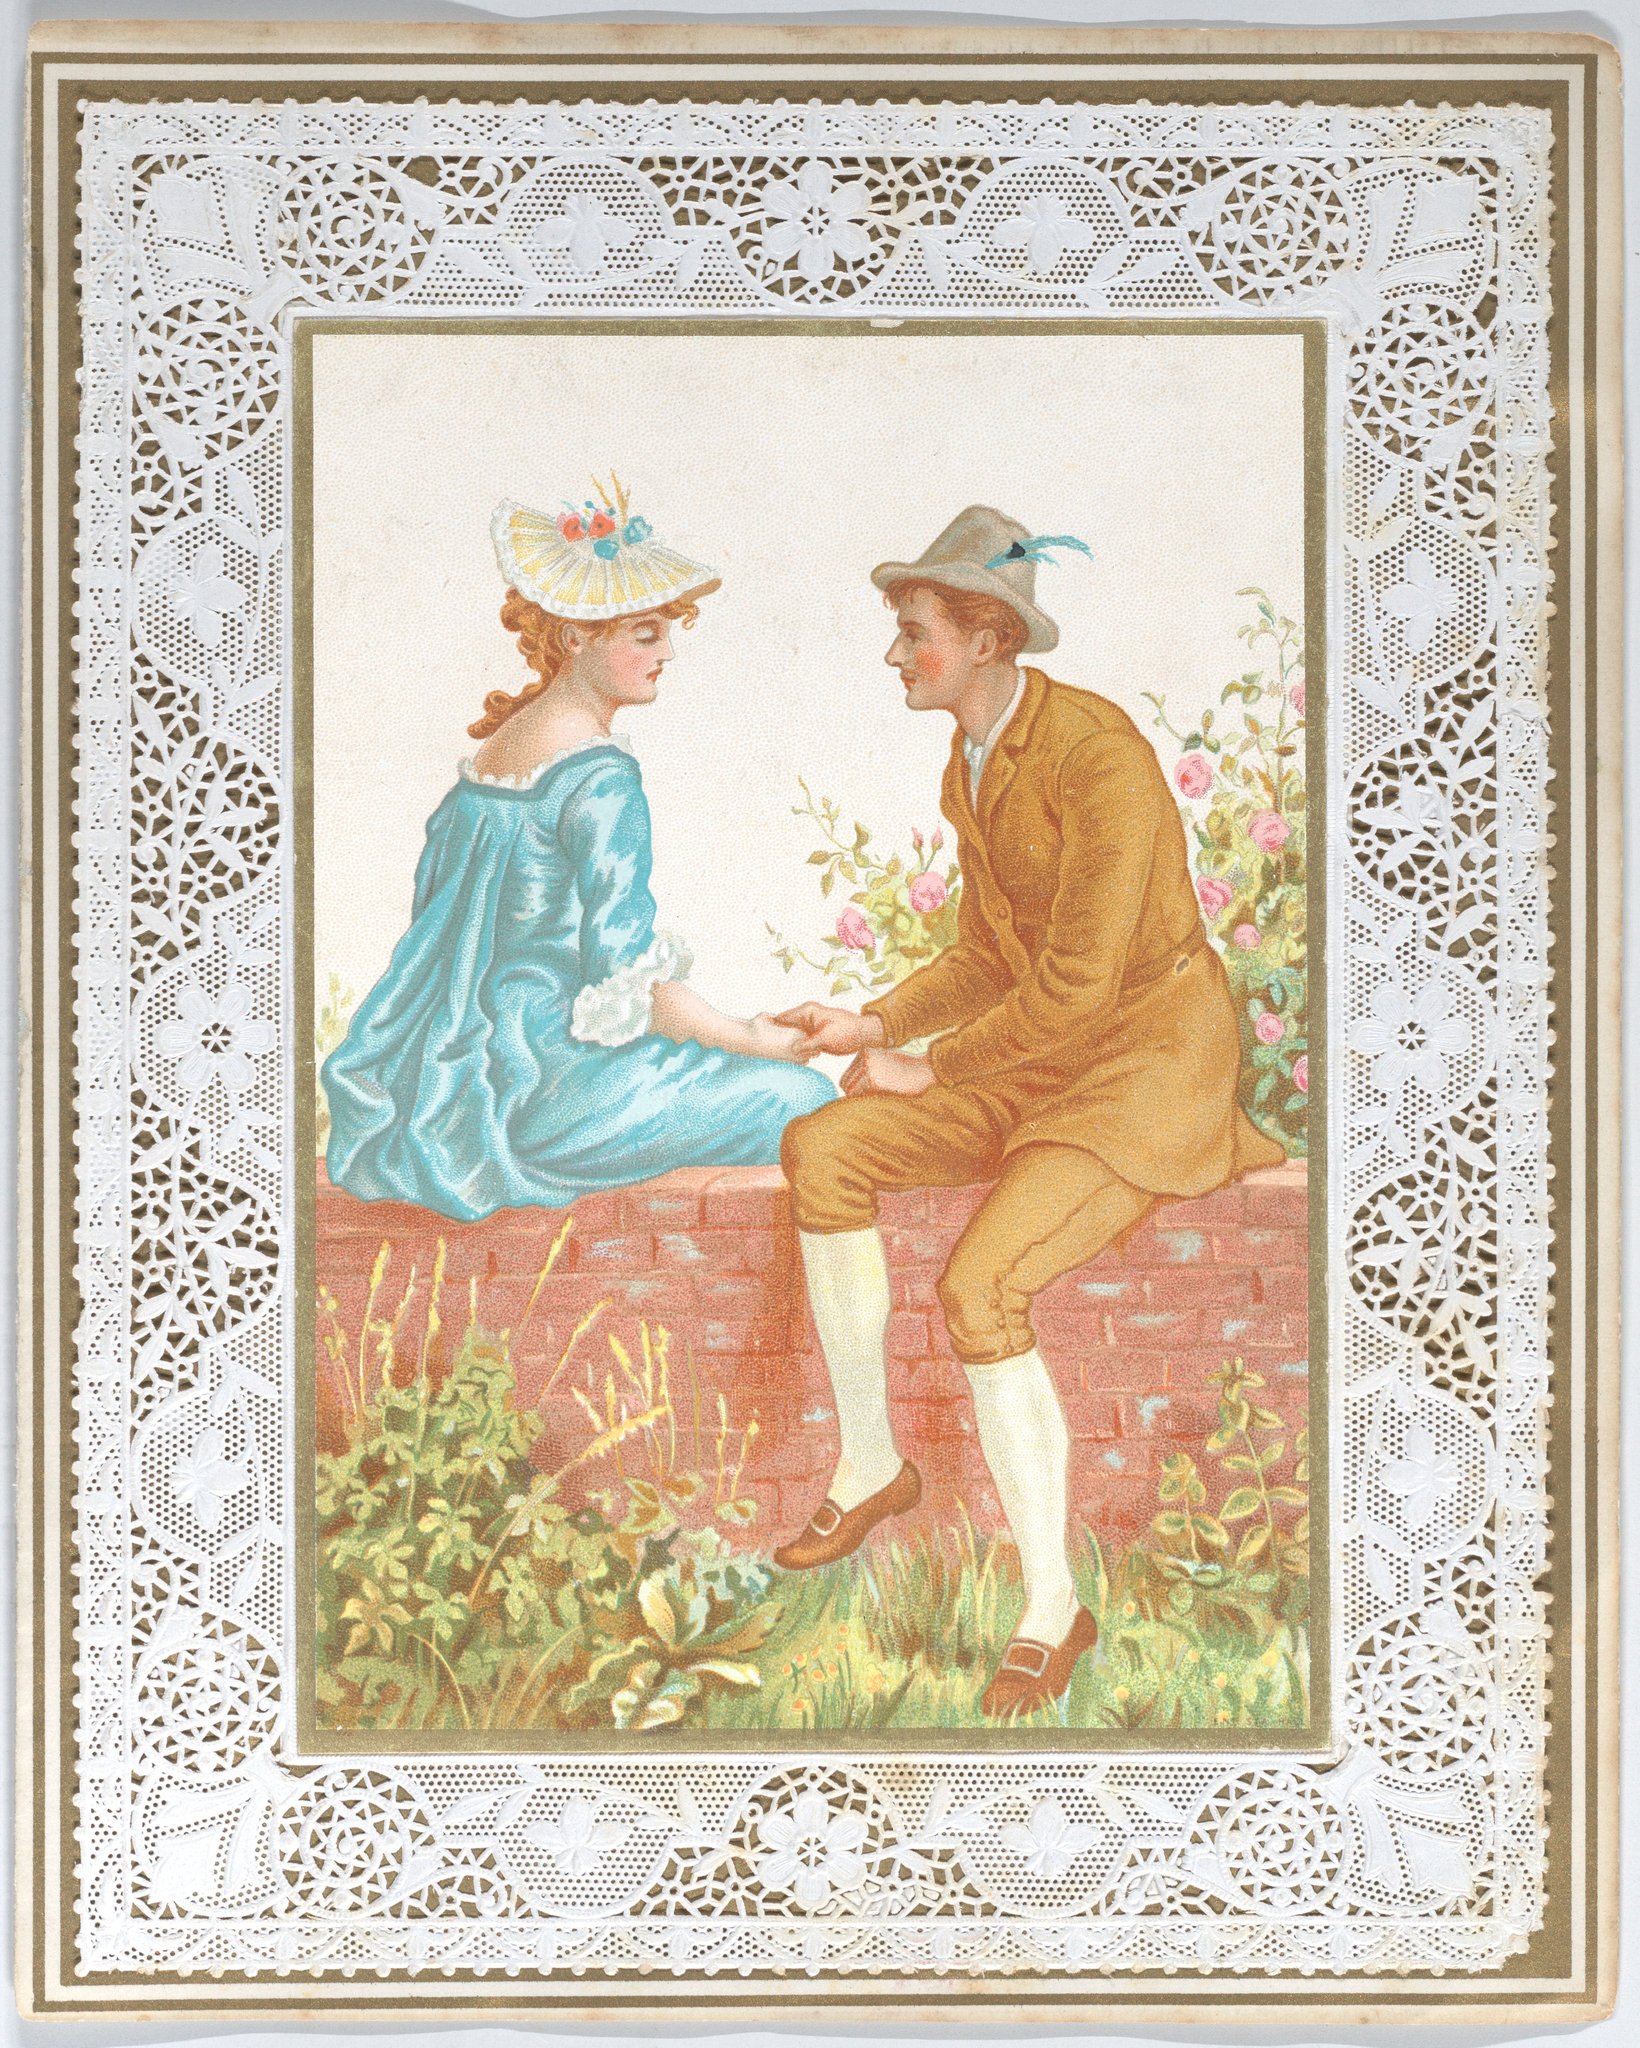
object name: valentine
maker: kate greenaway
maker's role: artist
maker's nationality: british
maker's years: 1846-1901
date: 1876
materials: gold, lace, paper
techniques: chromolithography, gilding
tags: couples,men,women